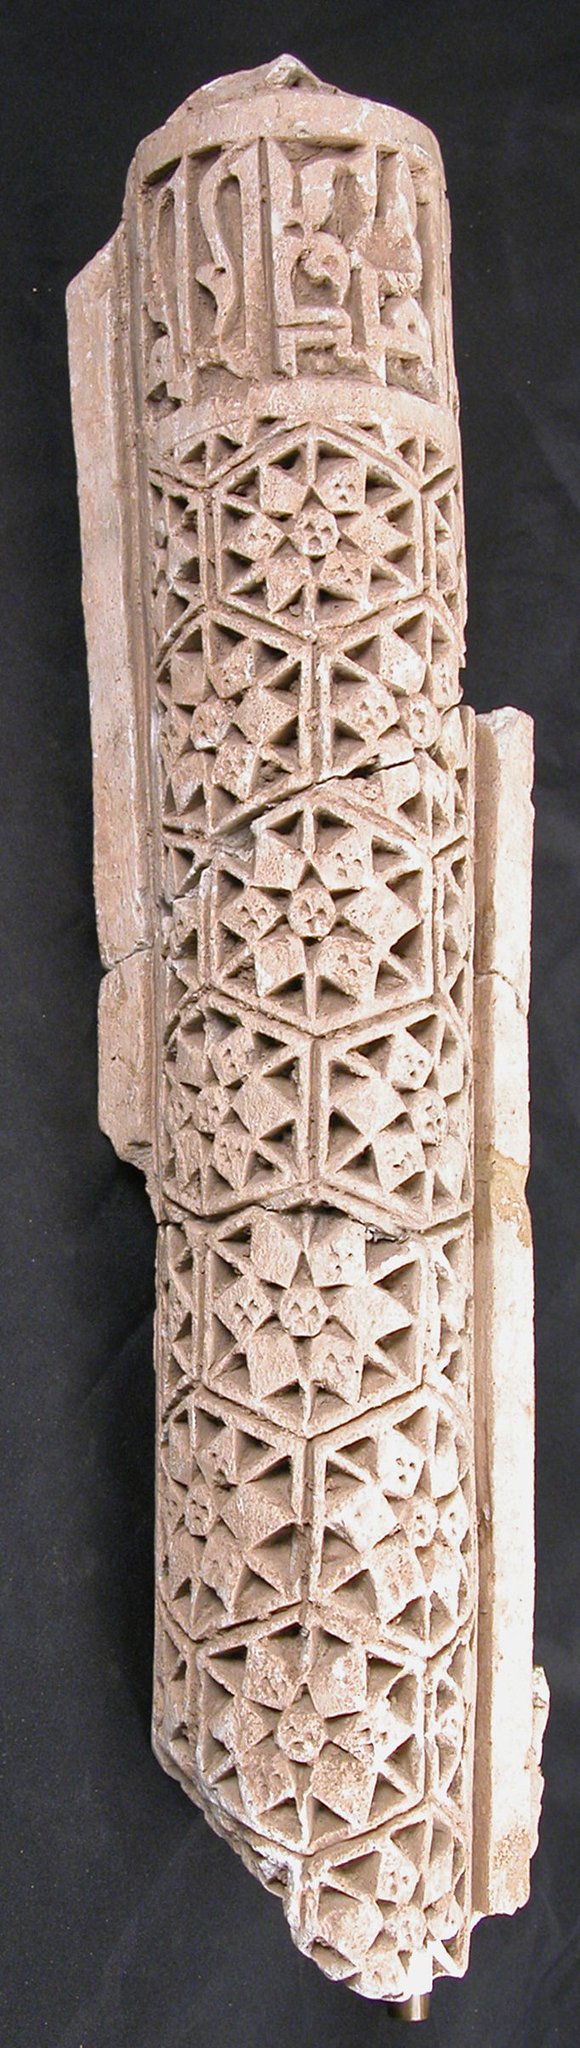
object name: column fragment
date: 901-1000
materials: plaster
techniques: carving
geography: iran